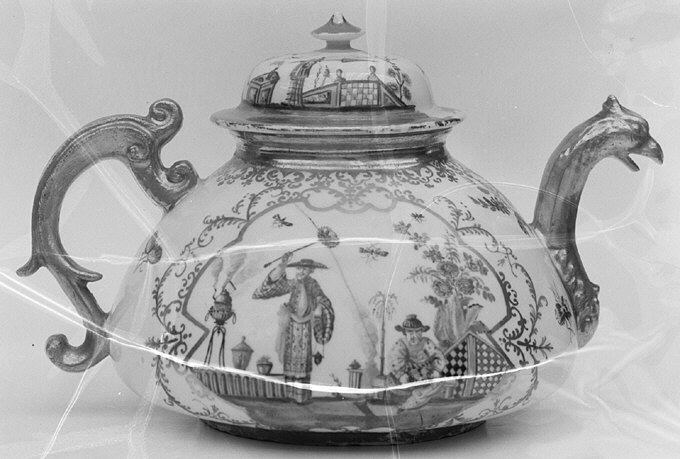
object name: teapot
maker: meissen manufactory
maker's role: manufactory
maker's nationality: german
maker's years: 1710-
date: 1725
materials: hard paste porcelain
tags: men